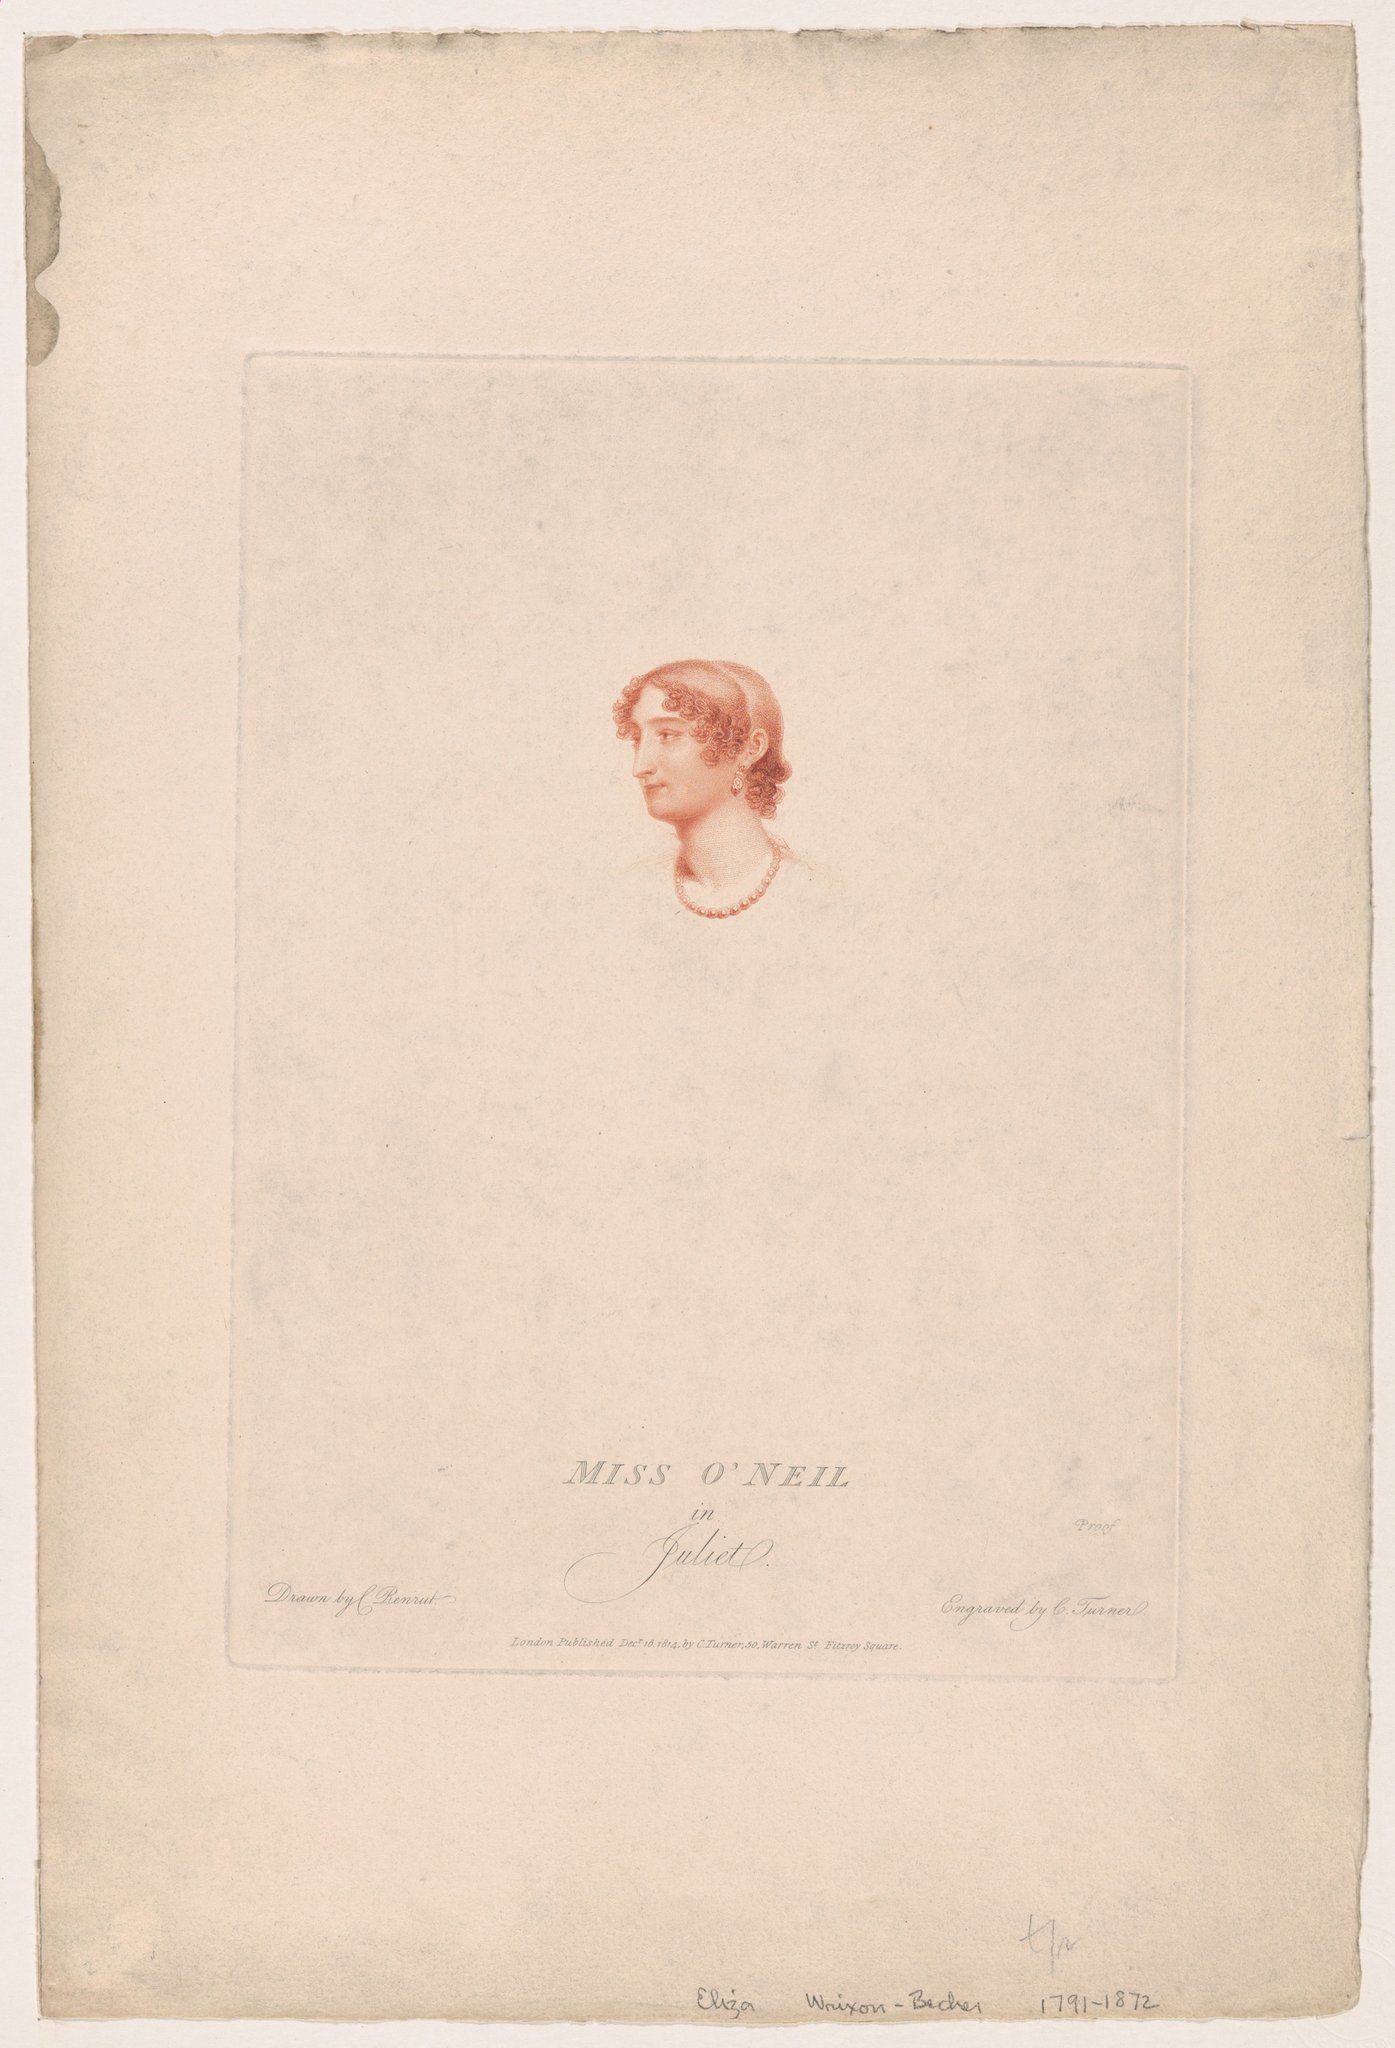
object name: print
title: Miss O'Neil in Juliet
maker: charles turner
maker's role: artist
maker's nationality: british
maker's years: 1774-1857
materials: ink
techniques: printing, engraving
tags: shakespeare,women,actresses